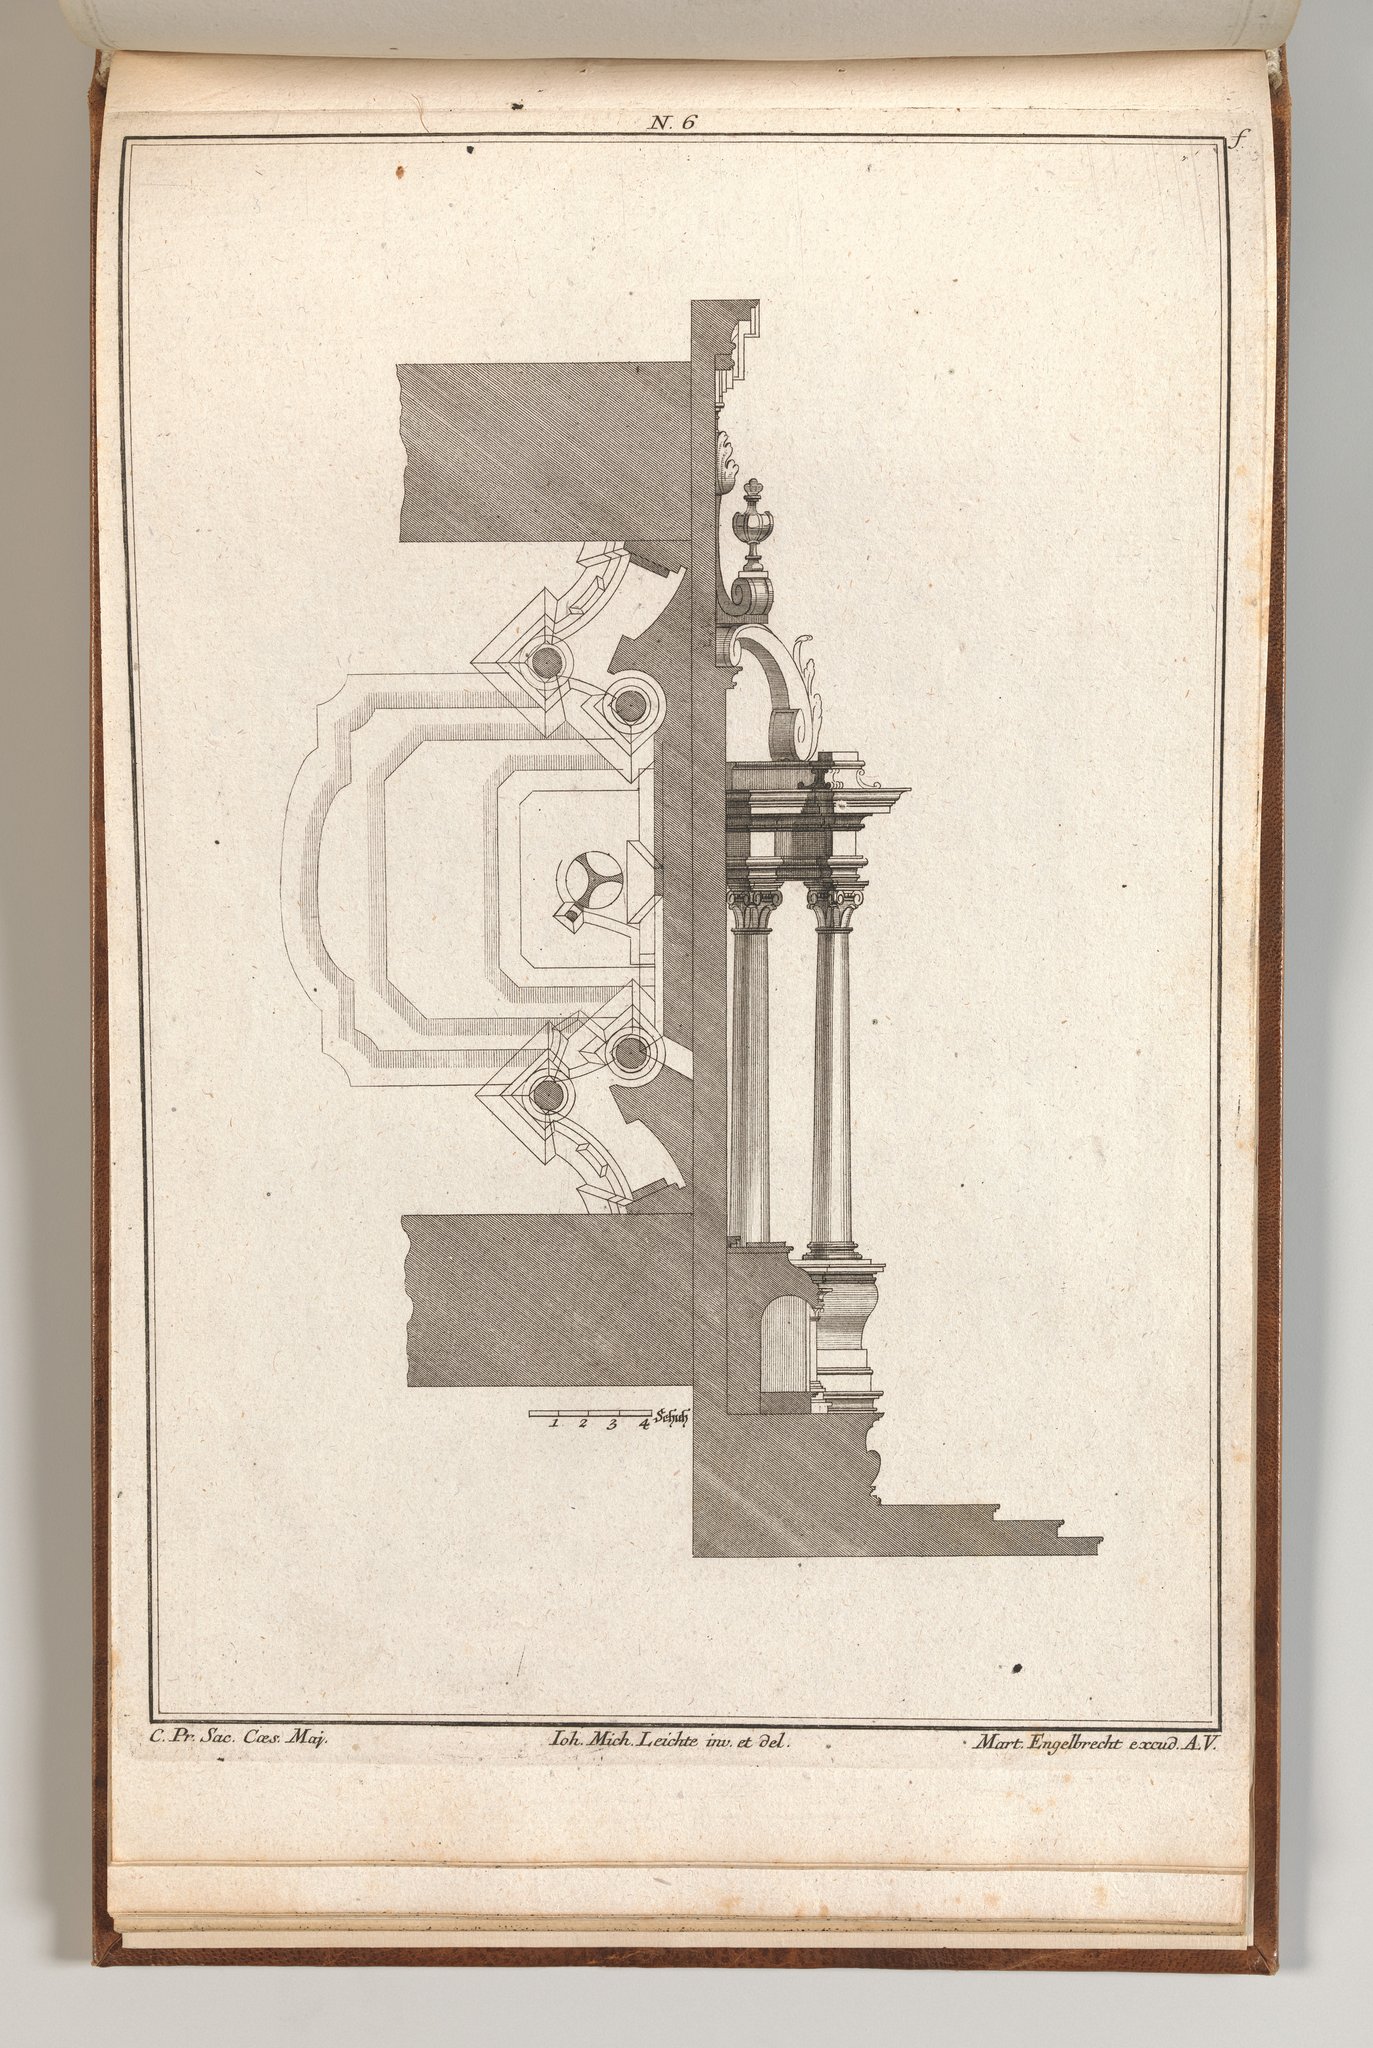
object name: album print ornament architecture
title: Floorplan and Side View of an Altar, Plate f (2) from 'Unterschiedliche Neu Inventierte Altäre mit darzu gehörigen Profillen u. Grundrißen.'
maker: johann michael leüchte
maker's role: artist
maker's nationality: german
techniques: etching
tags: altars